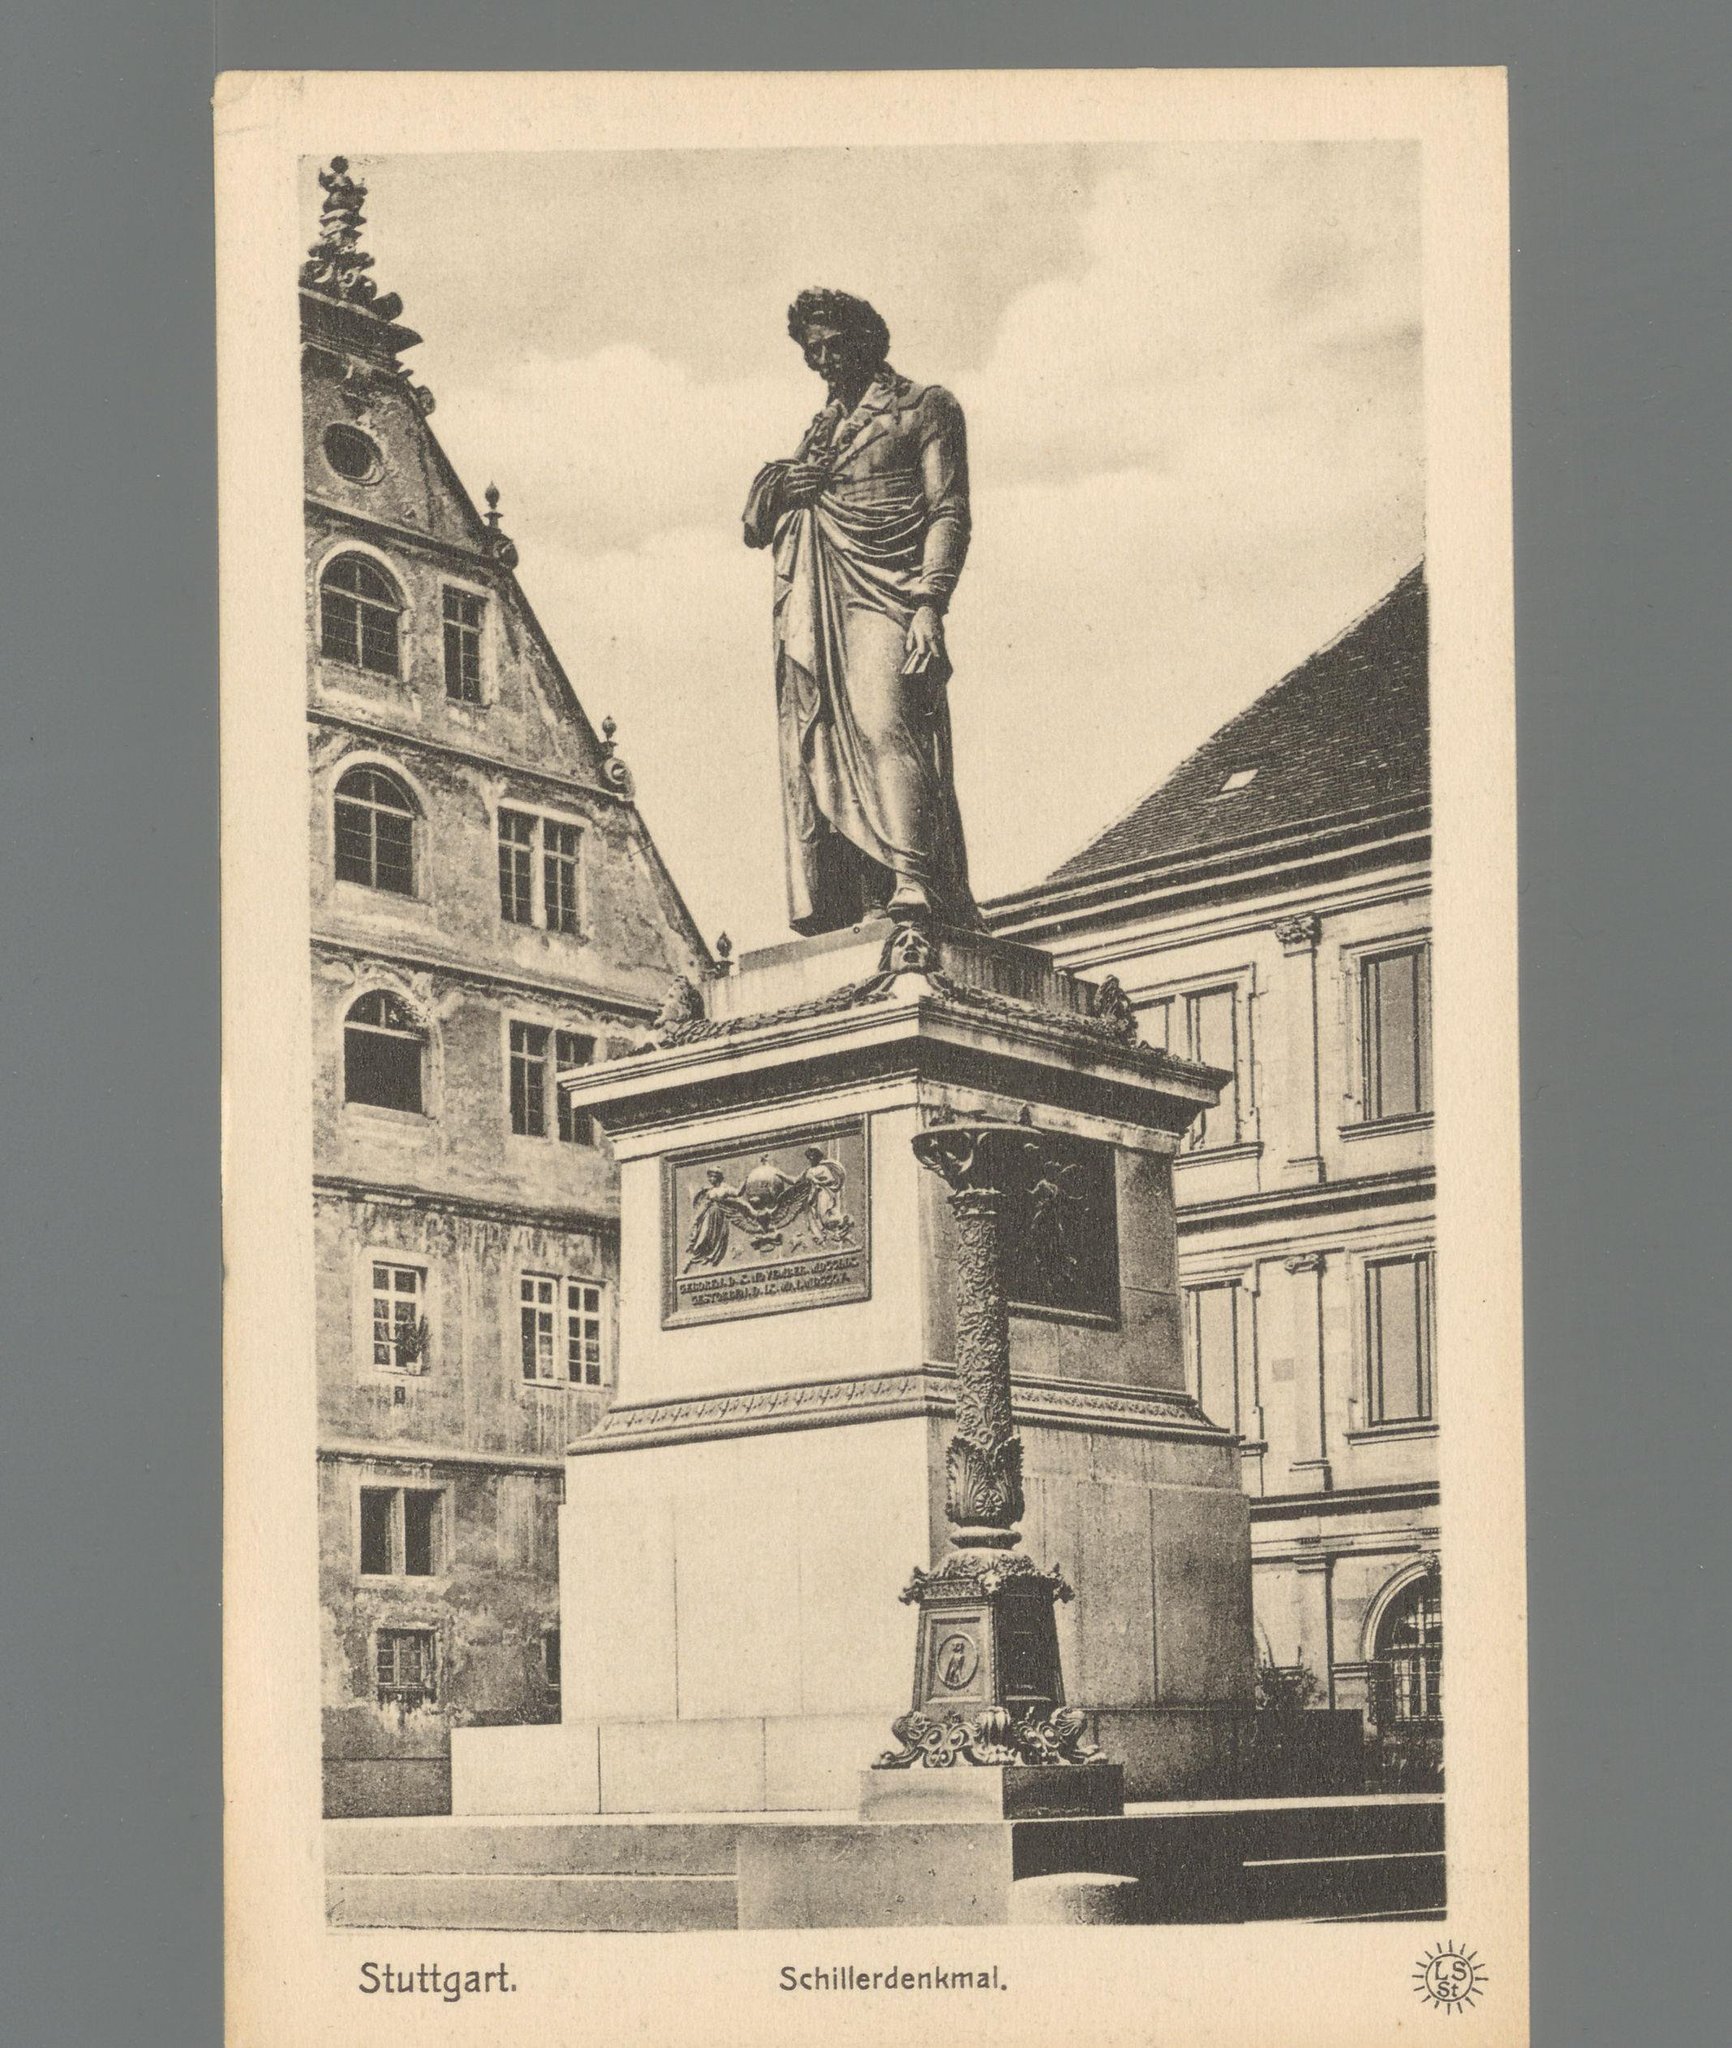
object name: photomechanical print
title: Stuttgart. Schillerdenkmal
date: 1906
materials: cardboard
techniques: photograph, writing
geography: stuttgart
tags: friedrich von schiller, monument, statue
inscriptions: date